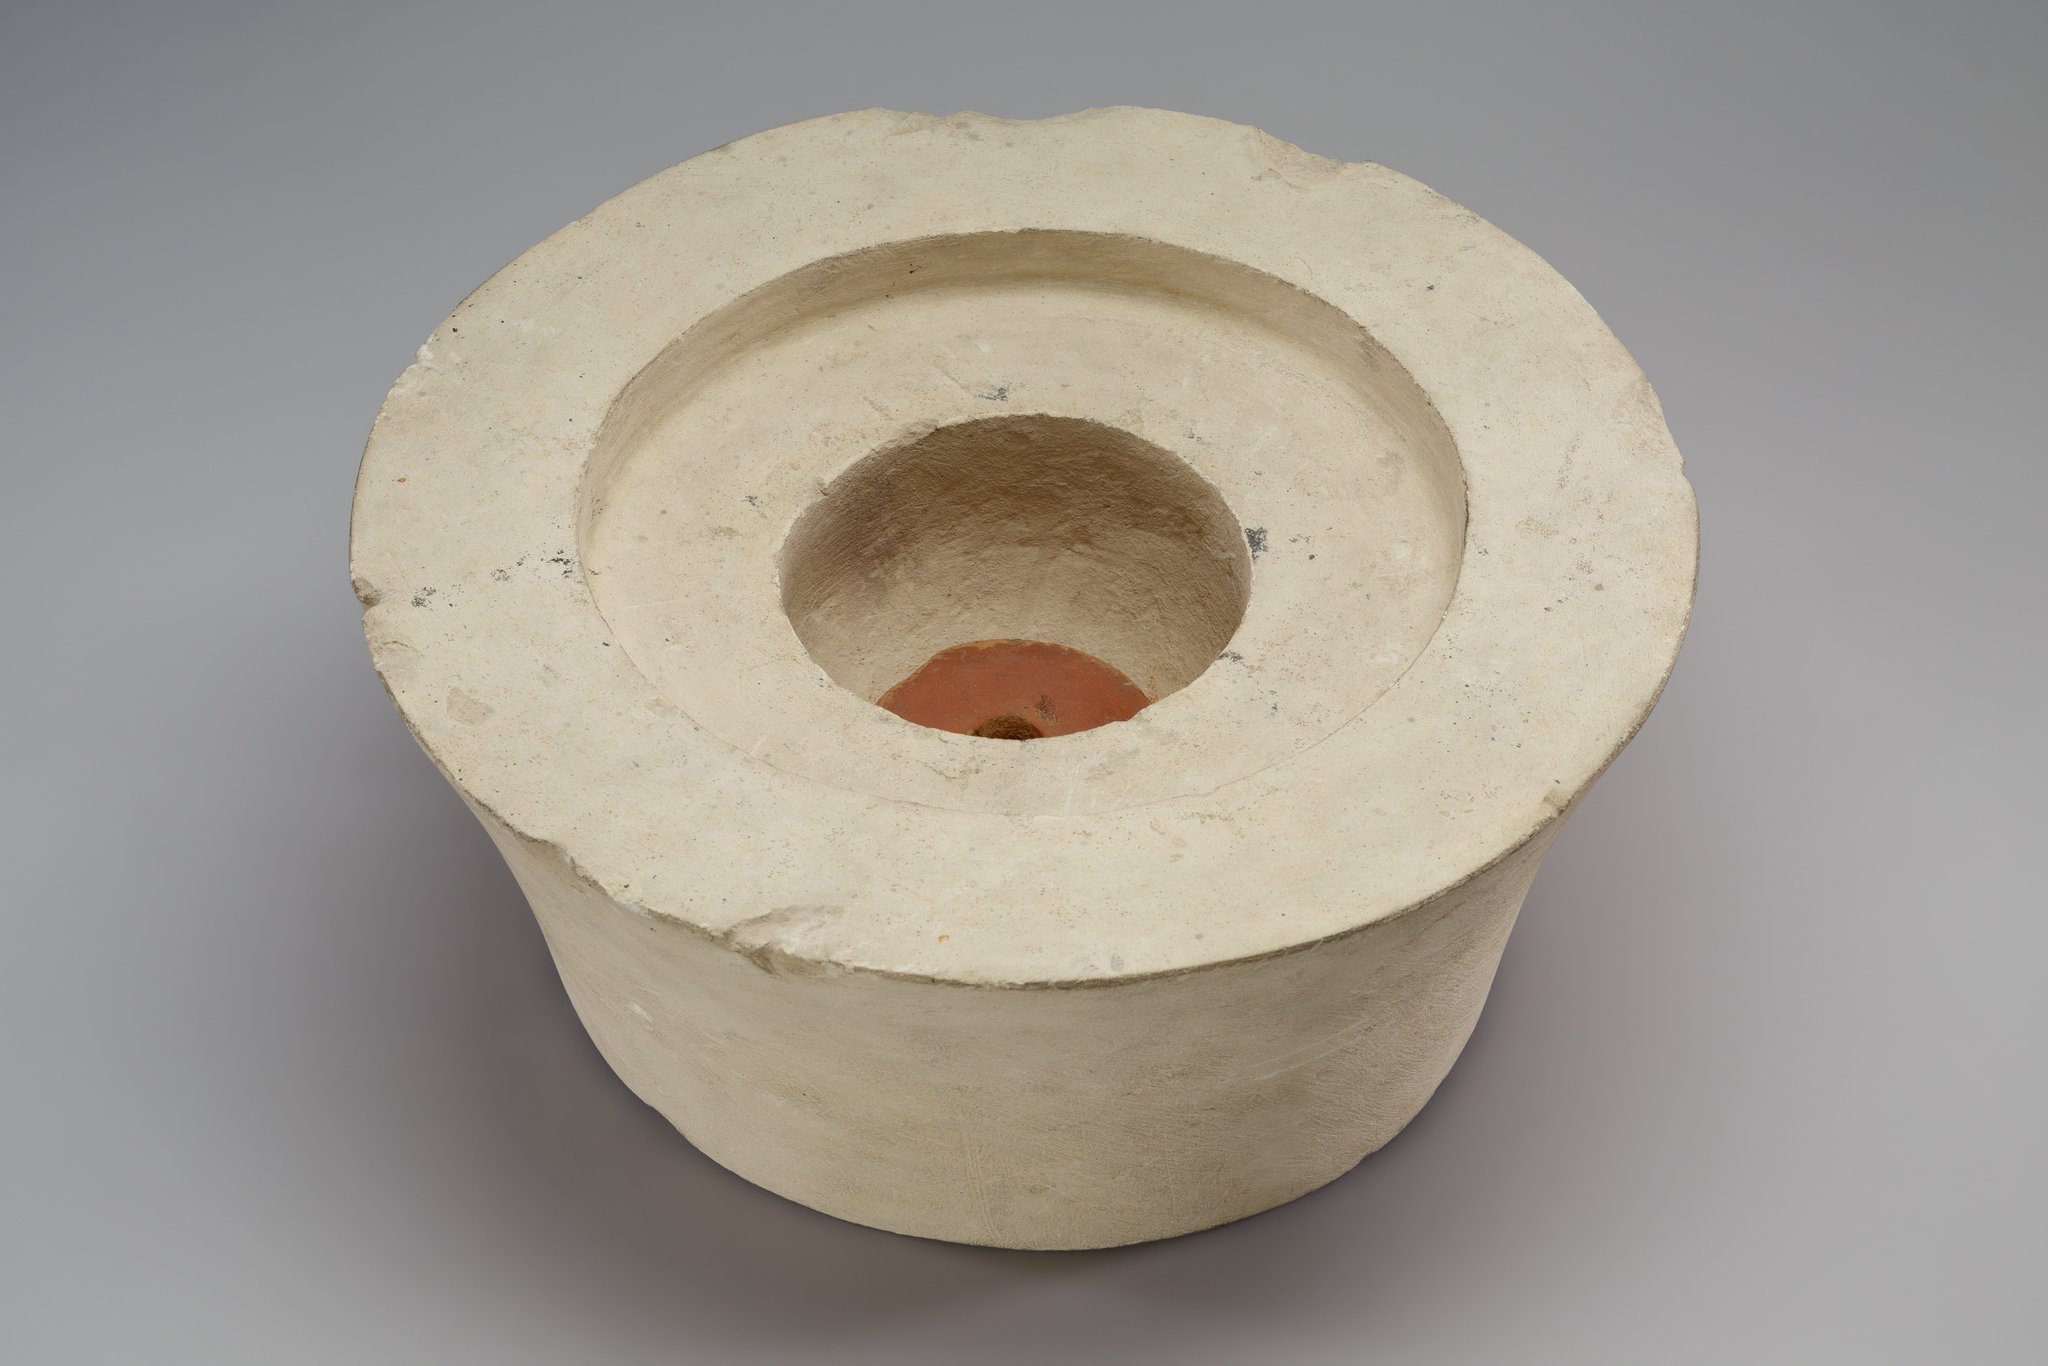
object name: lamp wick holder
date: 2030-1640 BCE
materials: limestone, pottery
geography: egypt